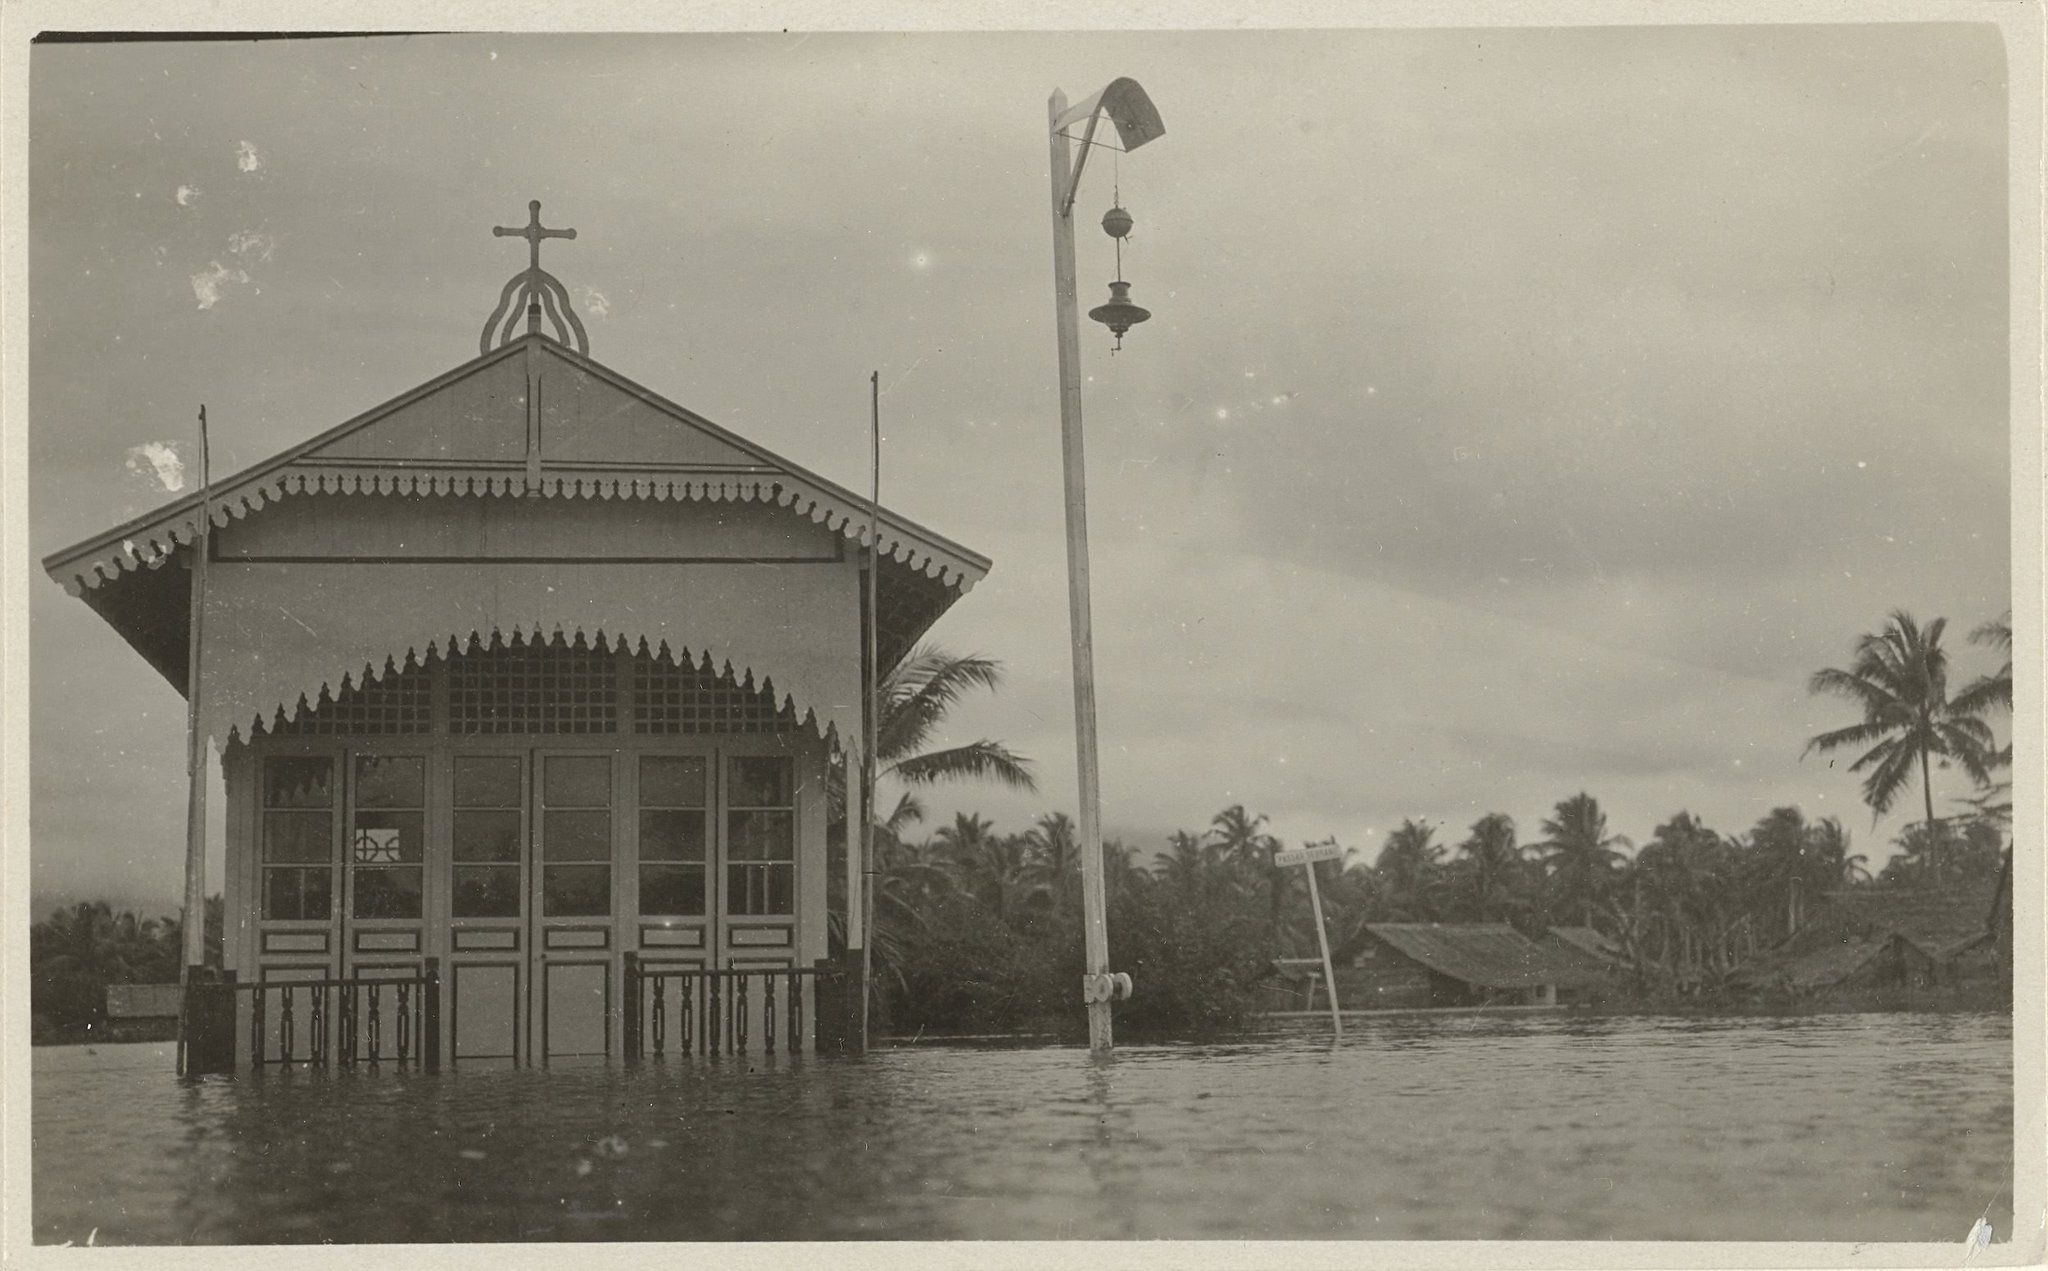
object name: photograph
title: Wateroverlast in Singkawang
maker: Anonymous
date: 1920-1940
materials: photographic support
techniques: gelatin silver print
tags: borneo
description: Onder water gelopen kerkje in Singkawang